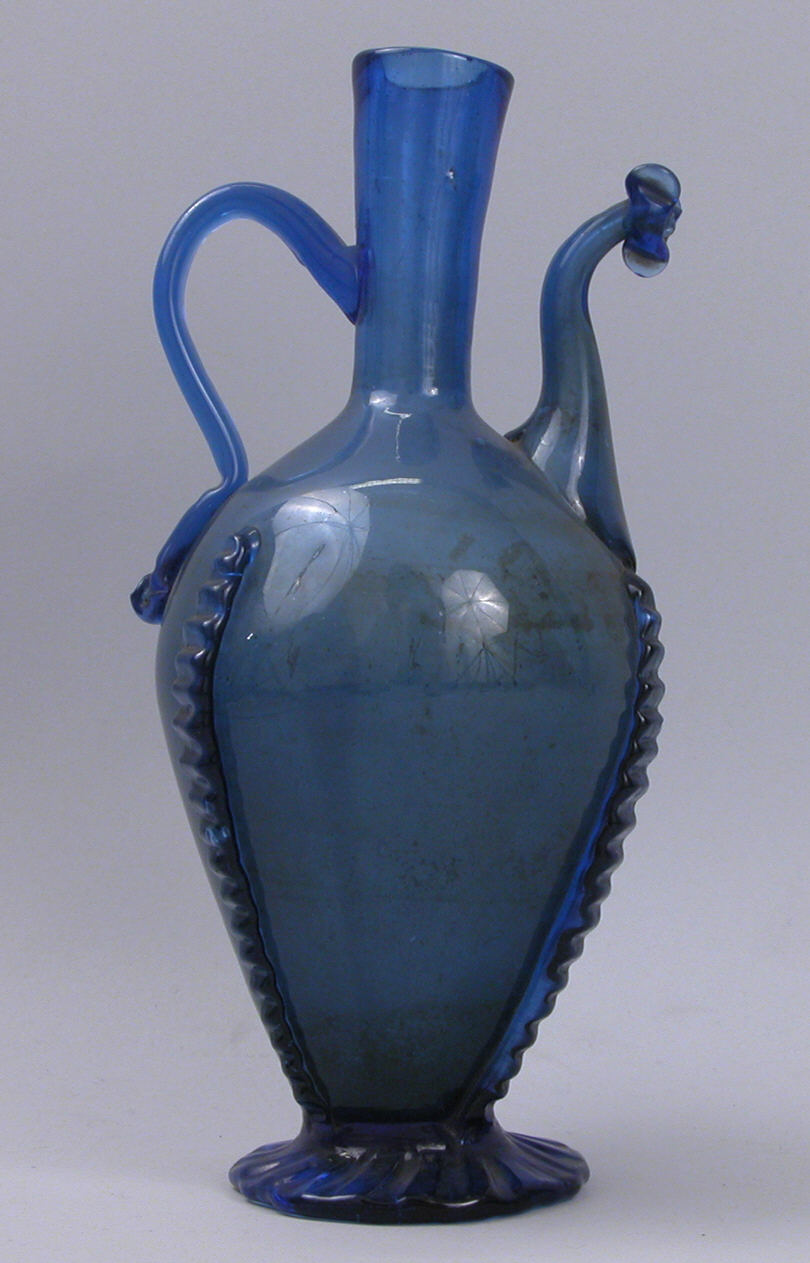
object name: ewer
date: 1701-1900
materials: glass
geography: iran